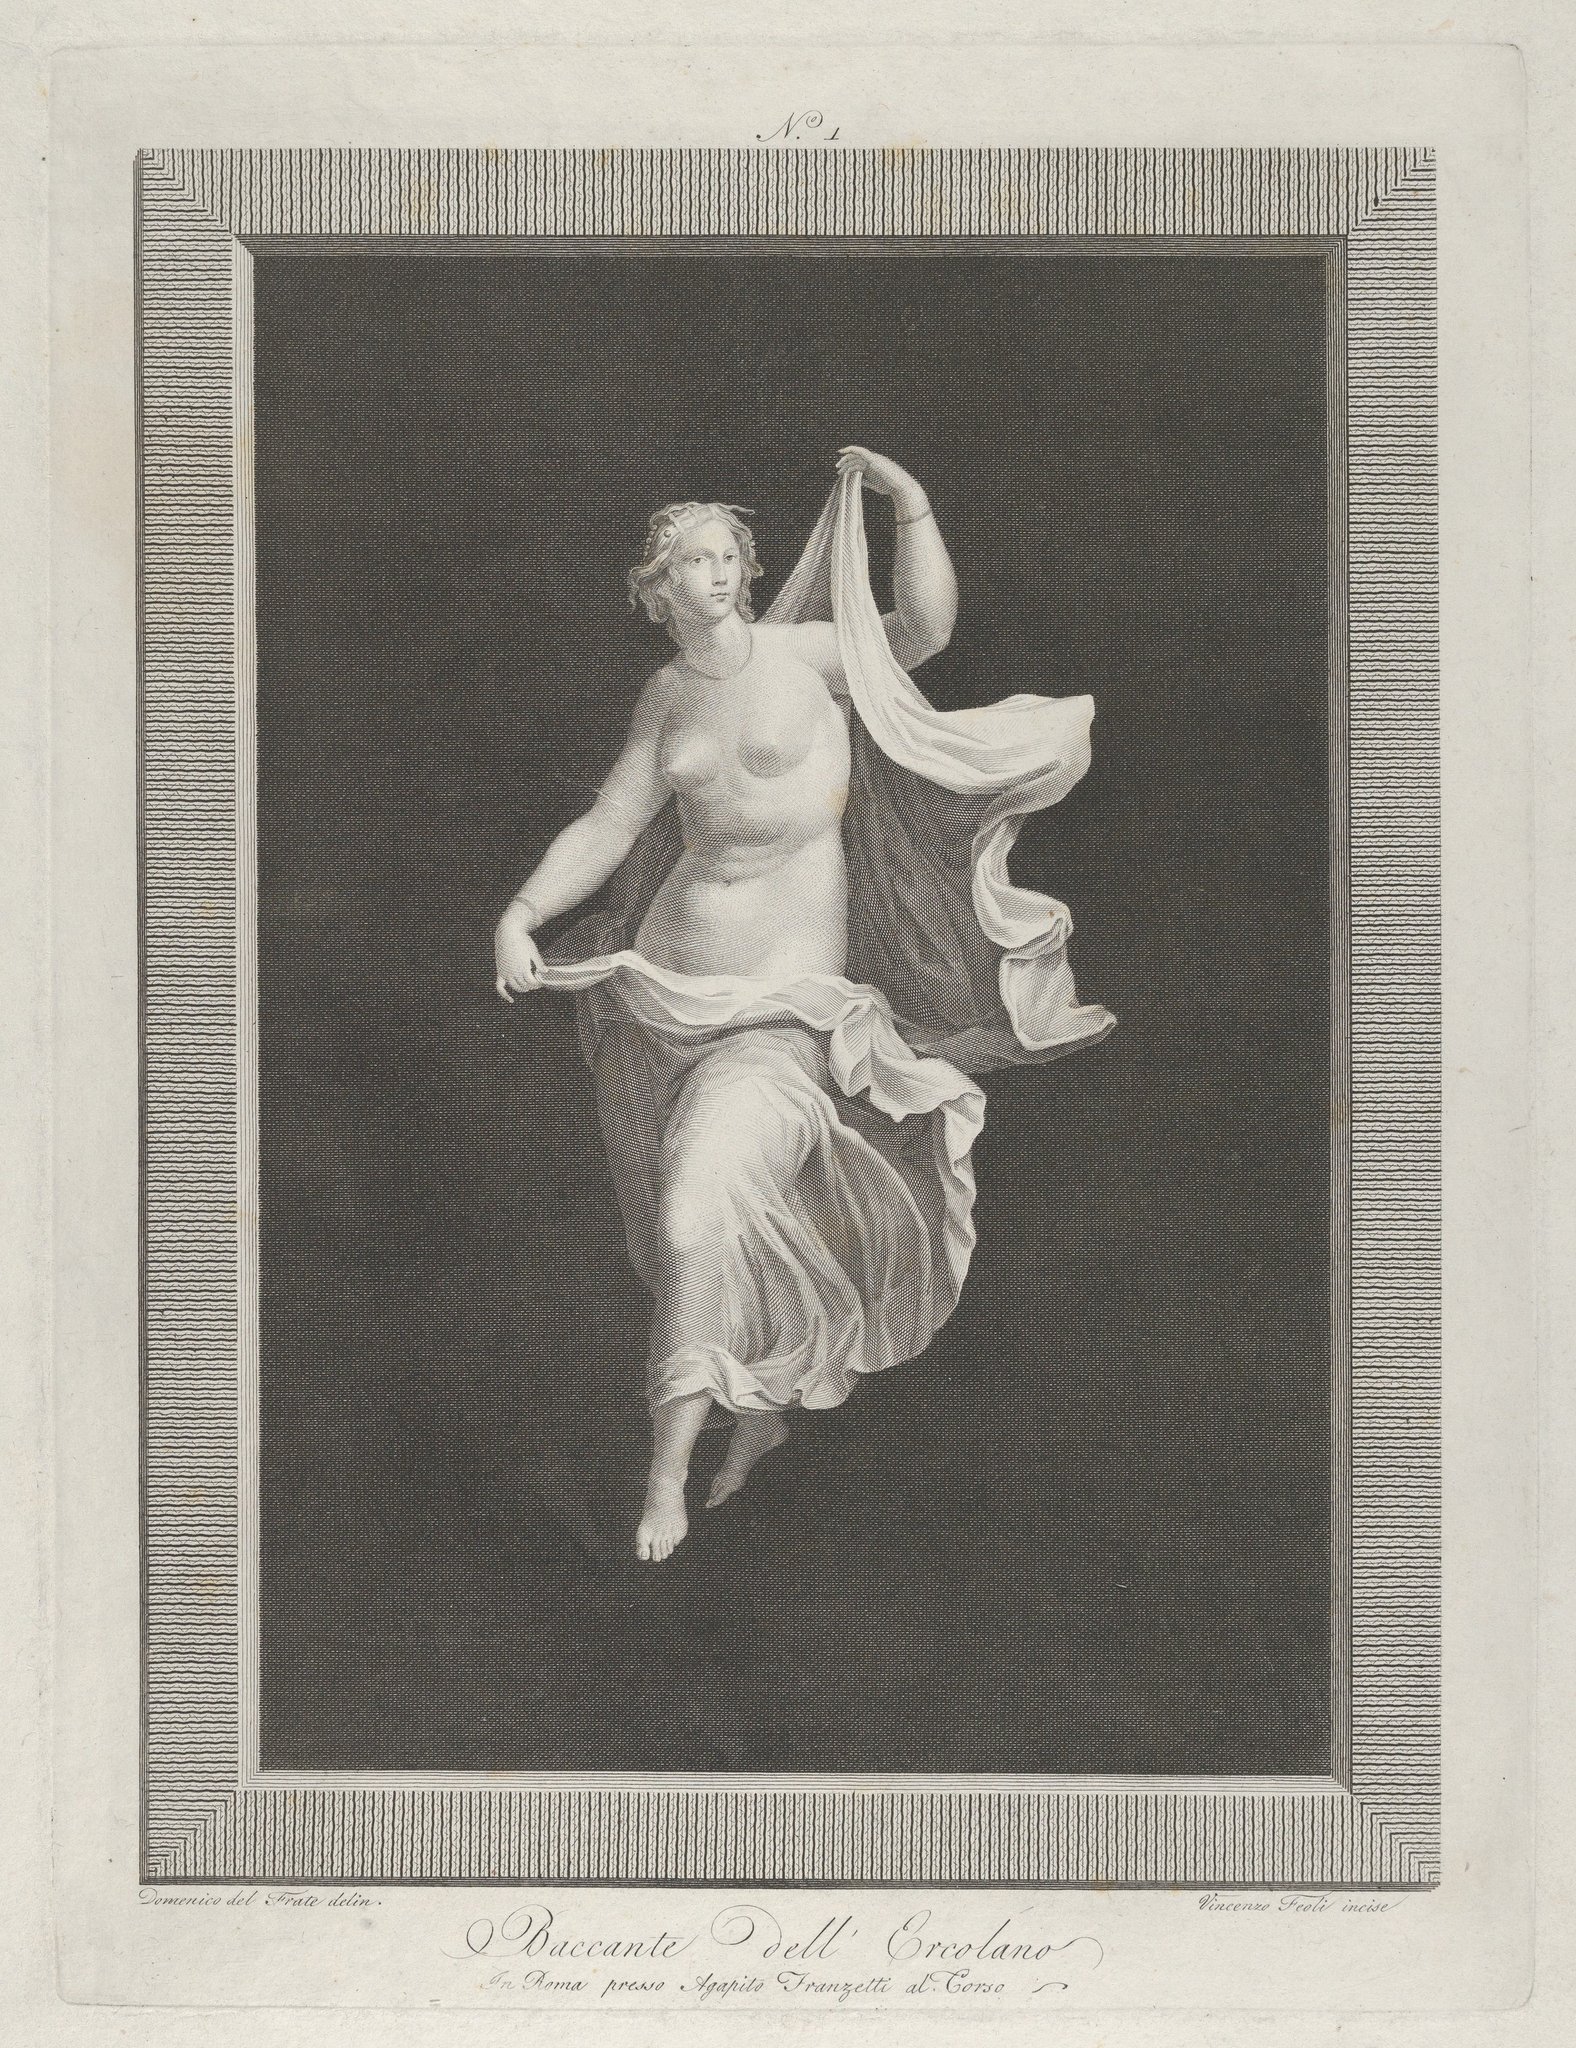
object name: print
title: A partly nude bacchante stepping forward and holding ends of her drapery in each hand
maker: vicenzo feoli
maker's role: artist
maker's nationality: italian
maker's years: 1755-1827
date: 1795-1820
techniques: engraving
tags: female nudes